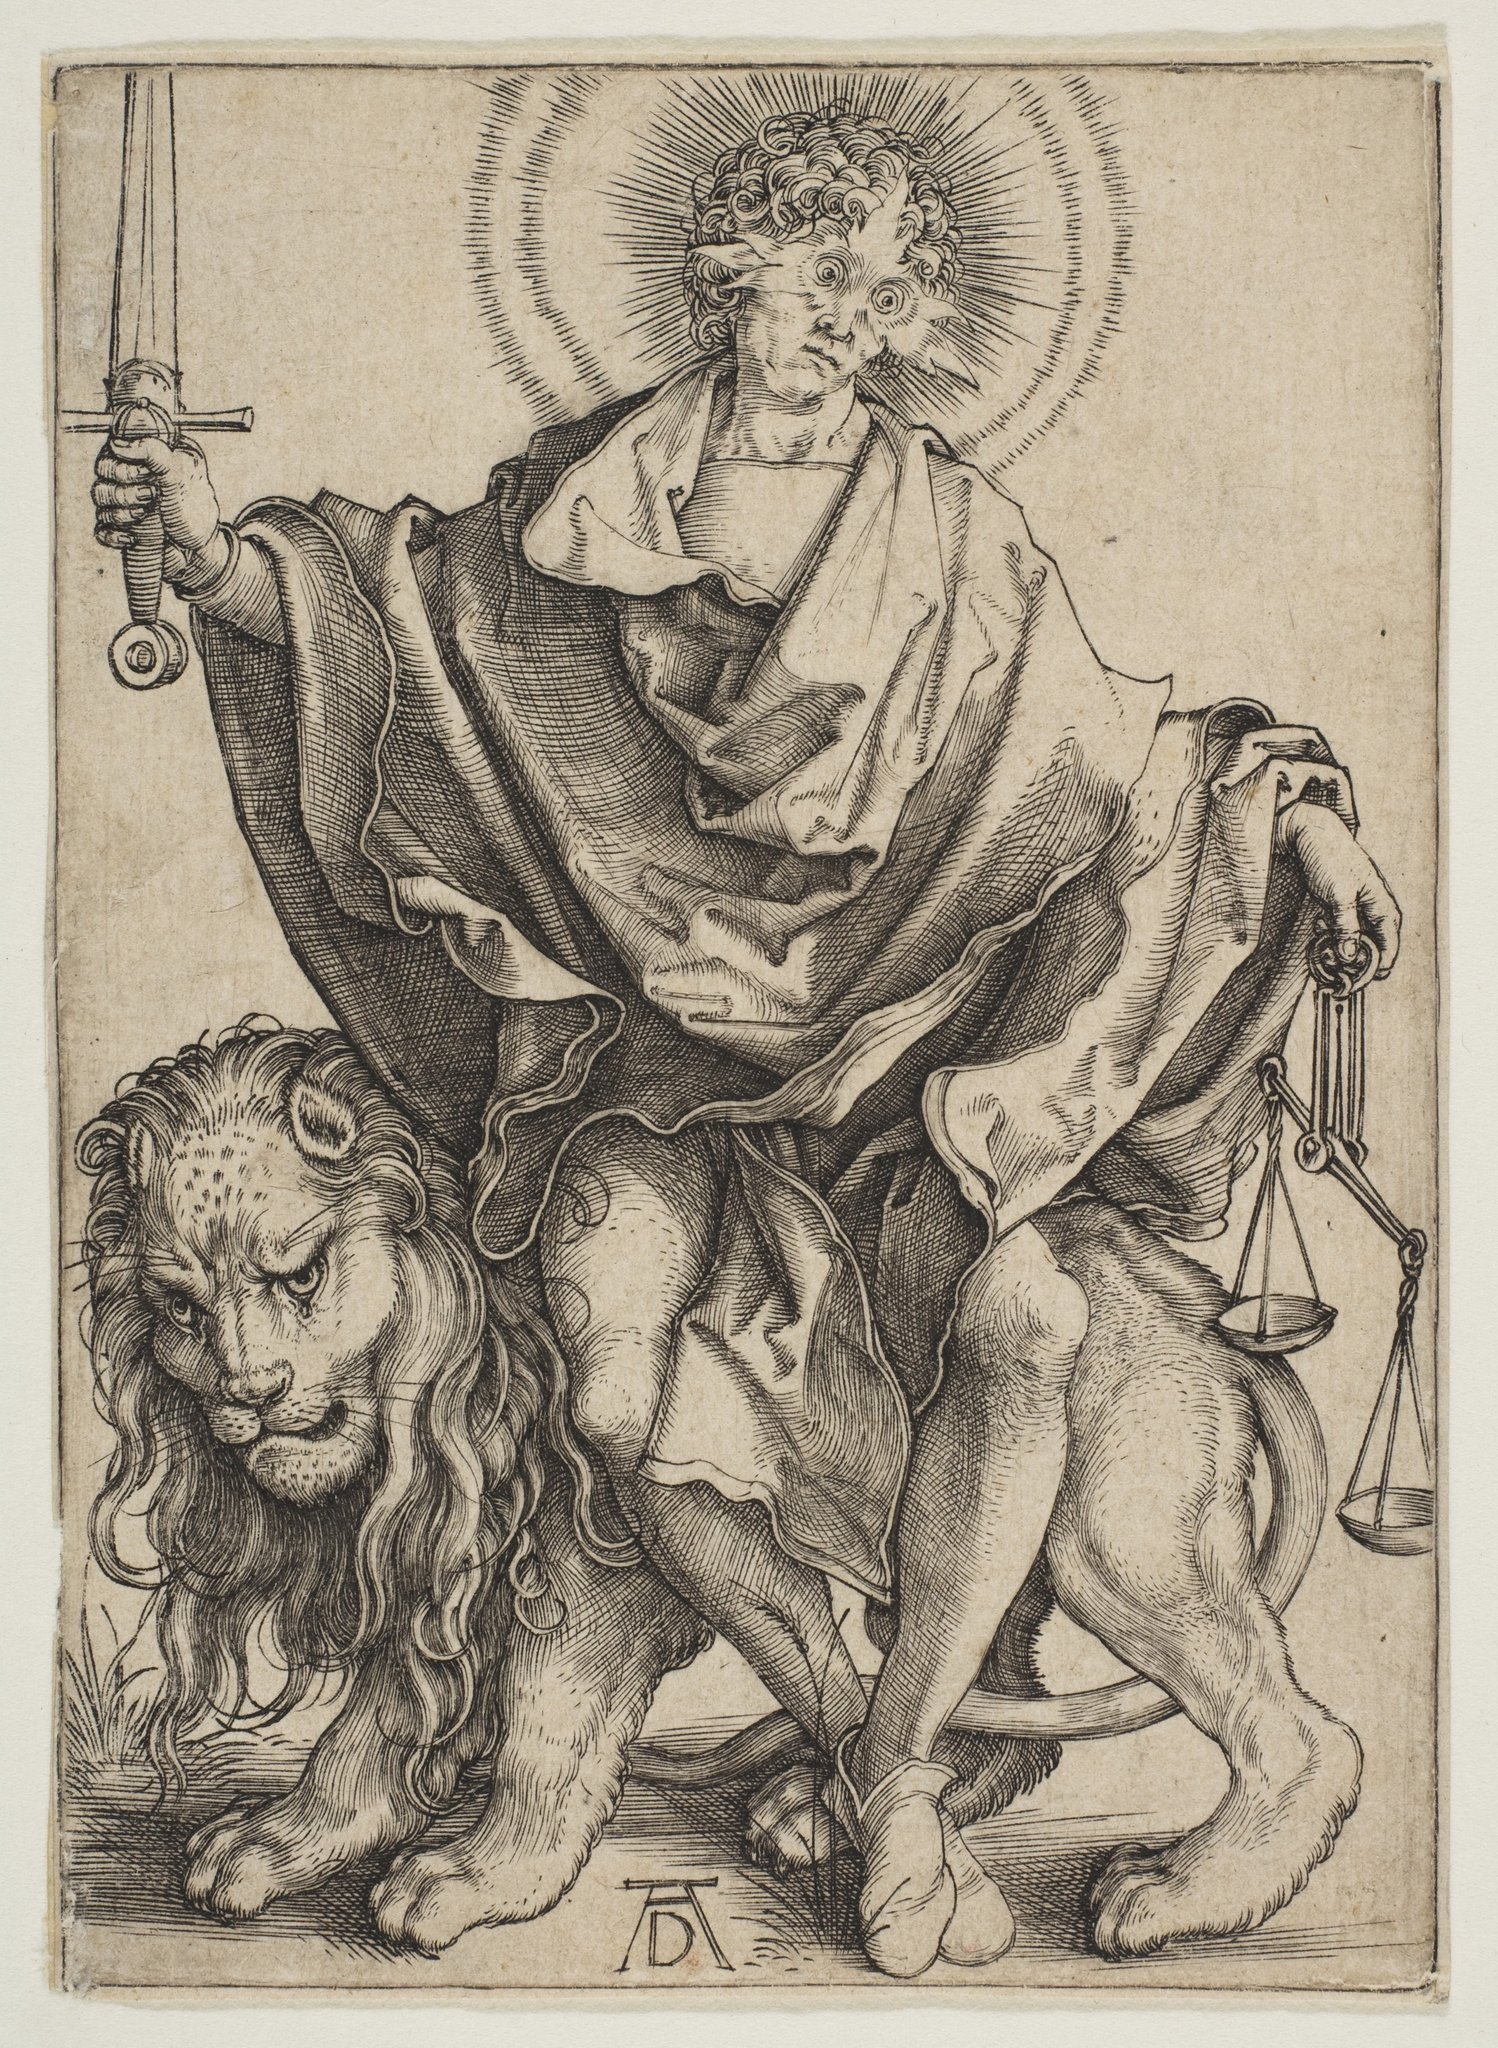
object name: print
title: Justice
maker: albrecht dürer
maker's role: artist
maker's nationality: german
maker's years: 1471-1528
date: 1499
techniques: engraving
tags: swords,lions,scales